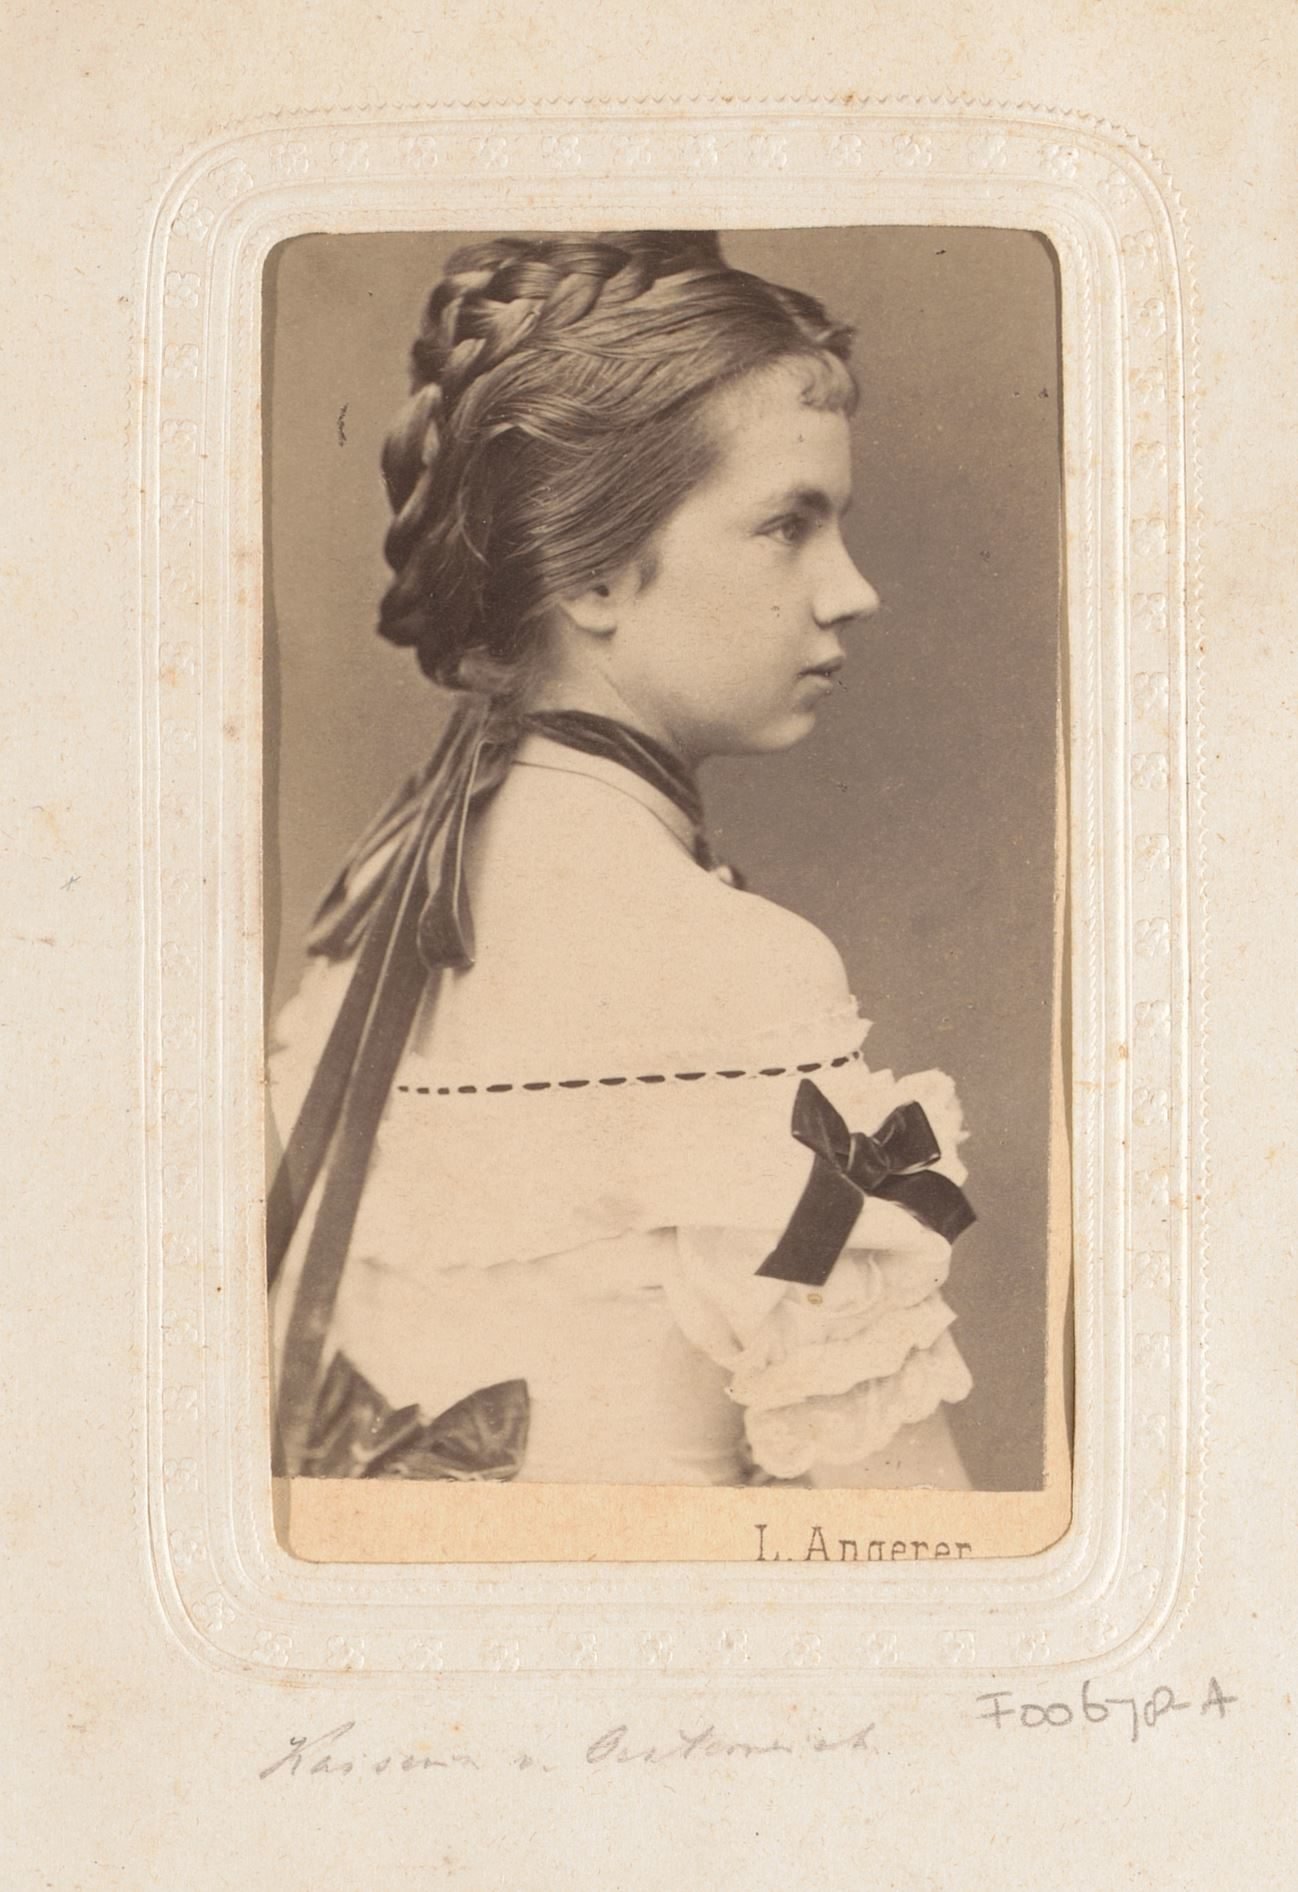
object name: album leaf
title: Portret van Elisabeth Amalie Eugenie in Beieren, keizerin van Oostenrijk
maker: ludwig angerer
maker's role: fotograaf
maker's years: 1827-1879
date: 1870-1880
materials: cardboard, photographic support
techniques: albumen print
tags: historical persons - bb - woman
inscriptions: inscription: ‘L. Angerer/ K.k. Hof-Photograph in Wien/ Stadt, Johannesgrasse’, annotation: ‘Kaiserin von Osterreich’